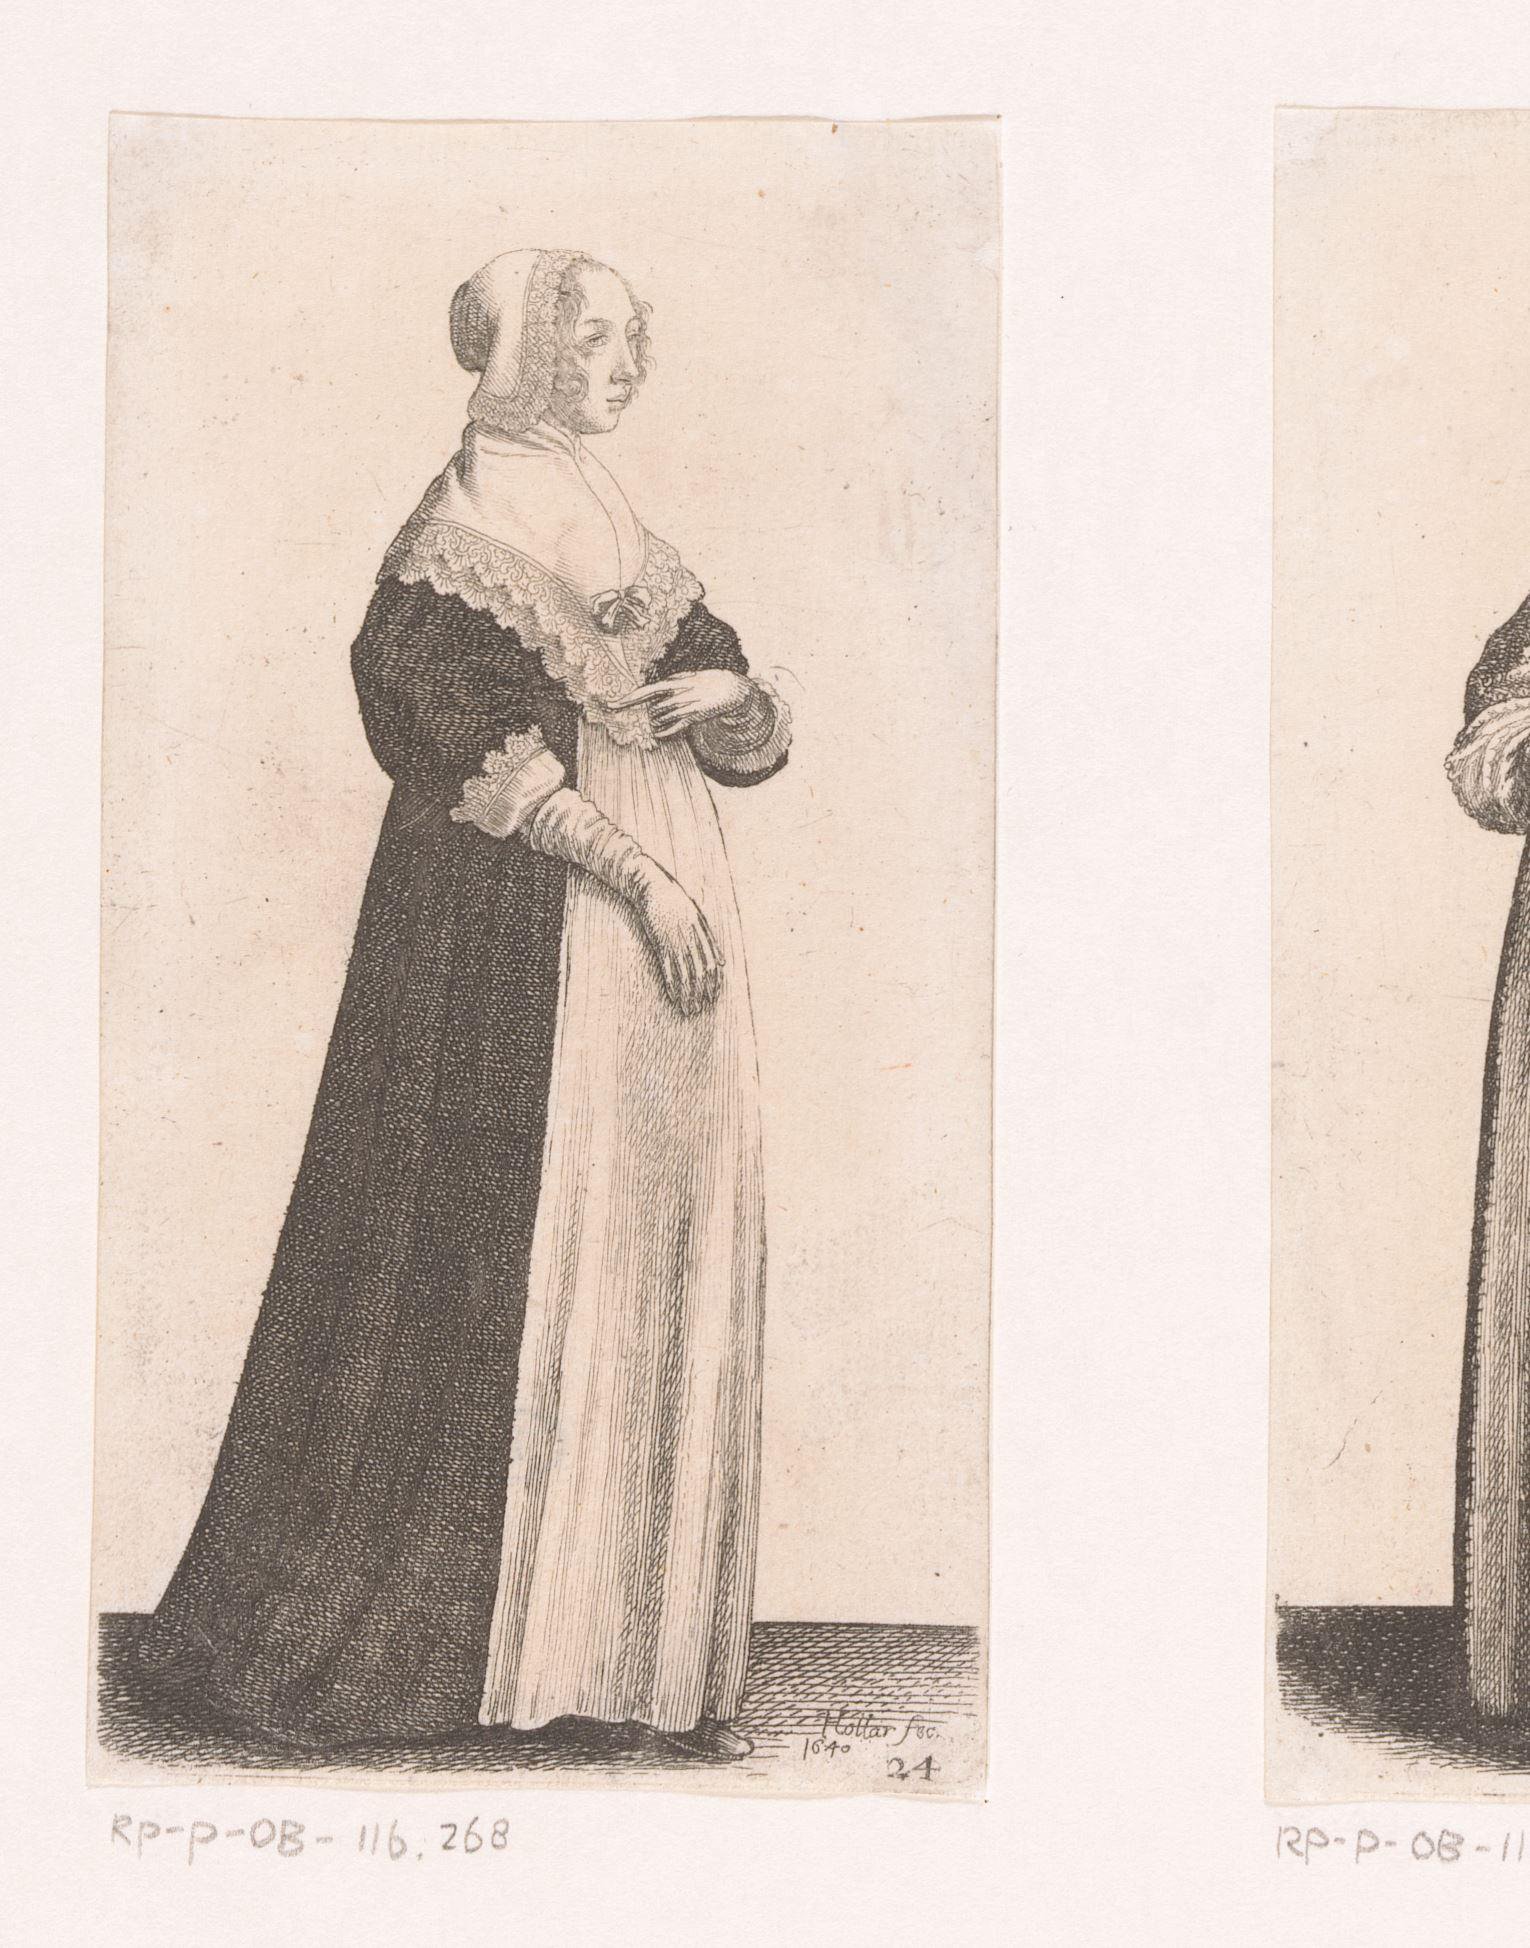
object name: costume print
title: Ornatus Muliebris Anglicanus / The Severall Habits of English Women, from the Nobilitie to the contry woman, they are in these times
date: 1640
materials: paper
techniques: etching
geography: london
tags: bow (ornamental part of clothing) (+ women's clothes), gloves, mittens (long gloves) (+ women's clothes), neck-gear ~ clothing (neckerchief) (+ women's clothes), gloves, mittens, etc. (+ leather used for clothes), europeans: englishmen (+ women), head-gear: cap (+ women's clothes), neck-gear: collar (+ women's clothes), clothes, costume (+ women's clothes), dress, gown (+ women's clothes), apron (+ women's clothes), clothes, costume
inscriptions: collector's mark: Lugt 2760, collector's mark: Lugt 2228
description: Engelse vrouw van stand met een mutsje afgezet met kant. Vanaf de nek tot over de schouders een halsdoek afgezet met een brede strook geschulpt kant, middenvoor gesloten met een strik. Haar japon heeft een witte short over een lange rok. Ze draagt lange handschoenen.